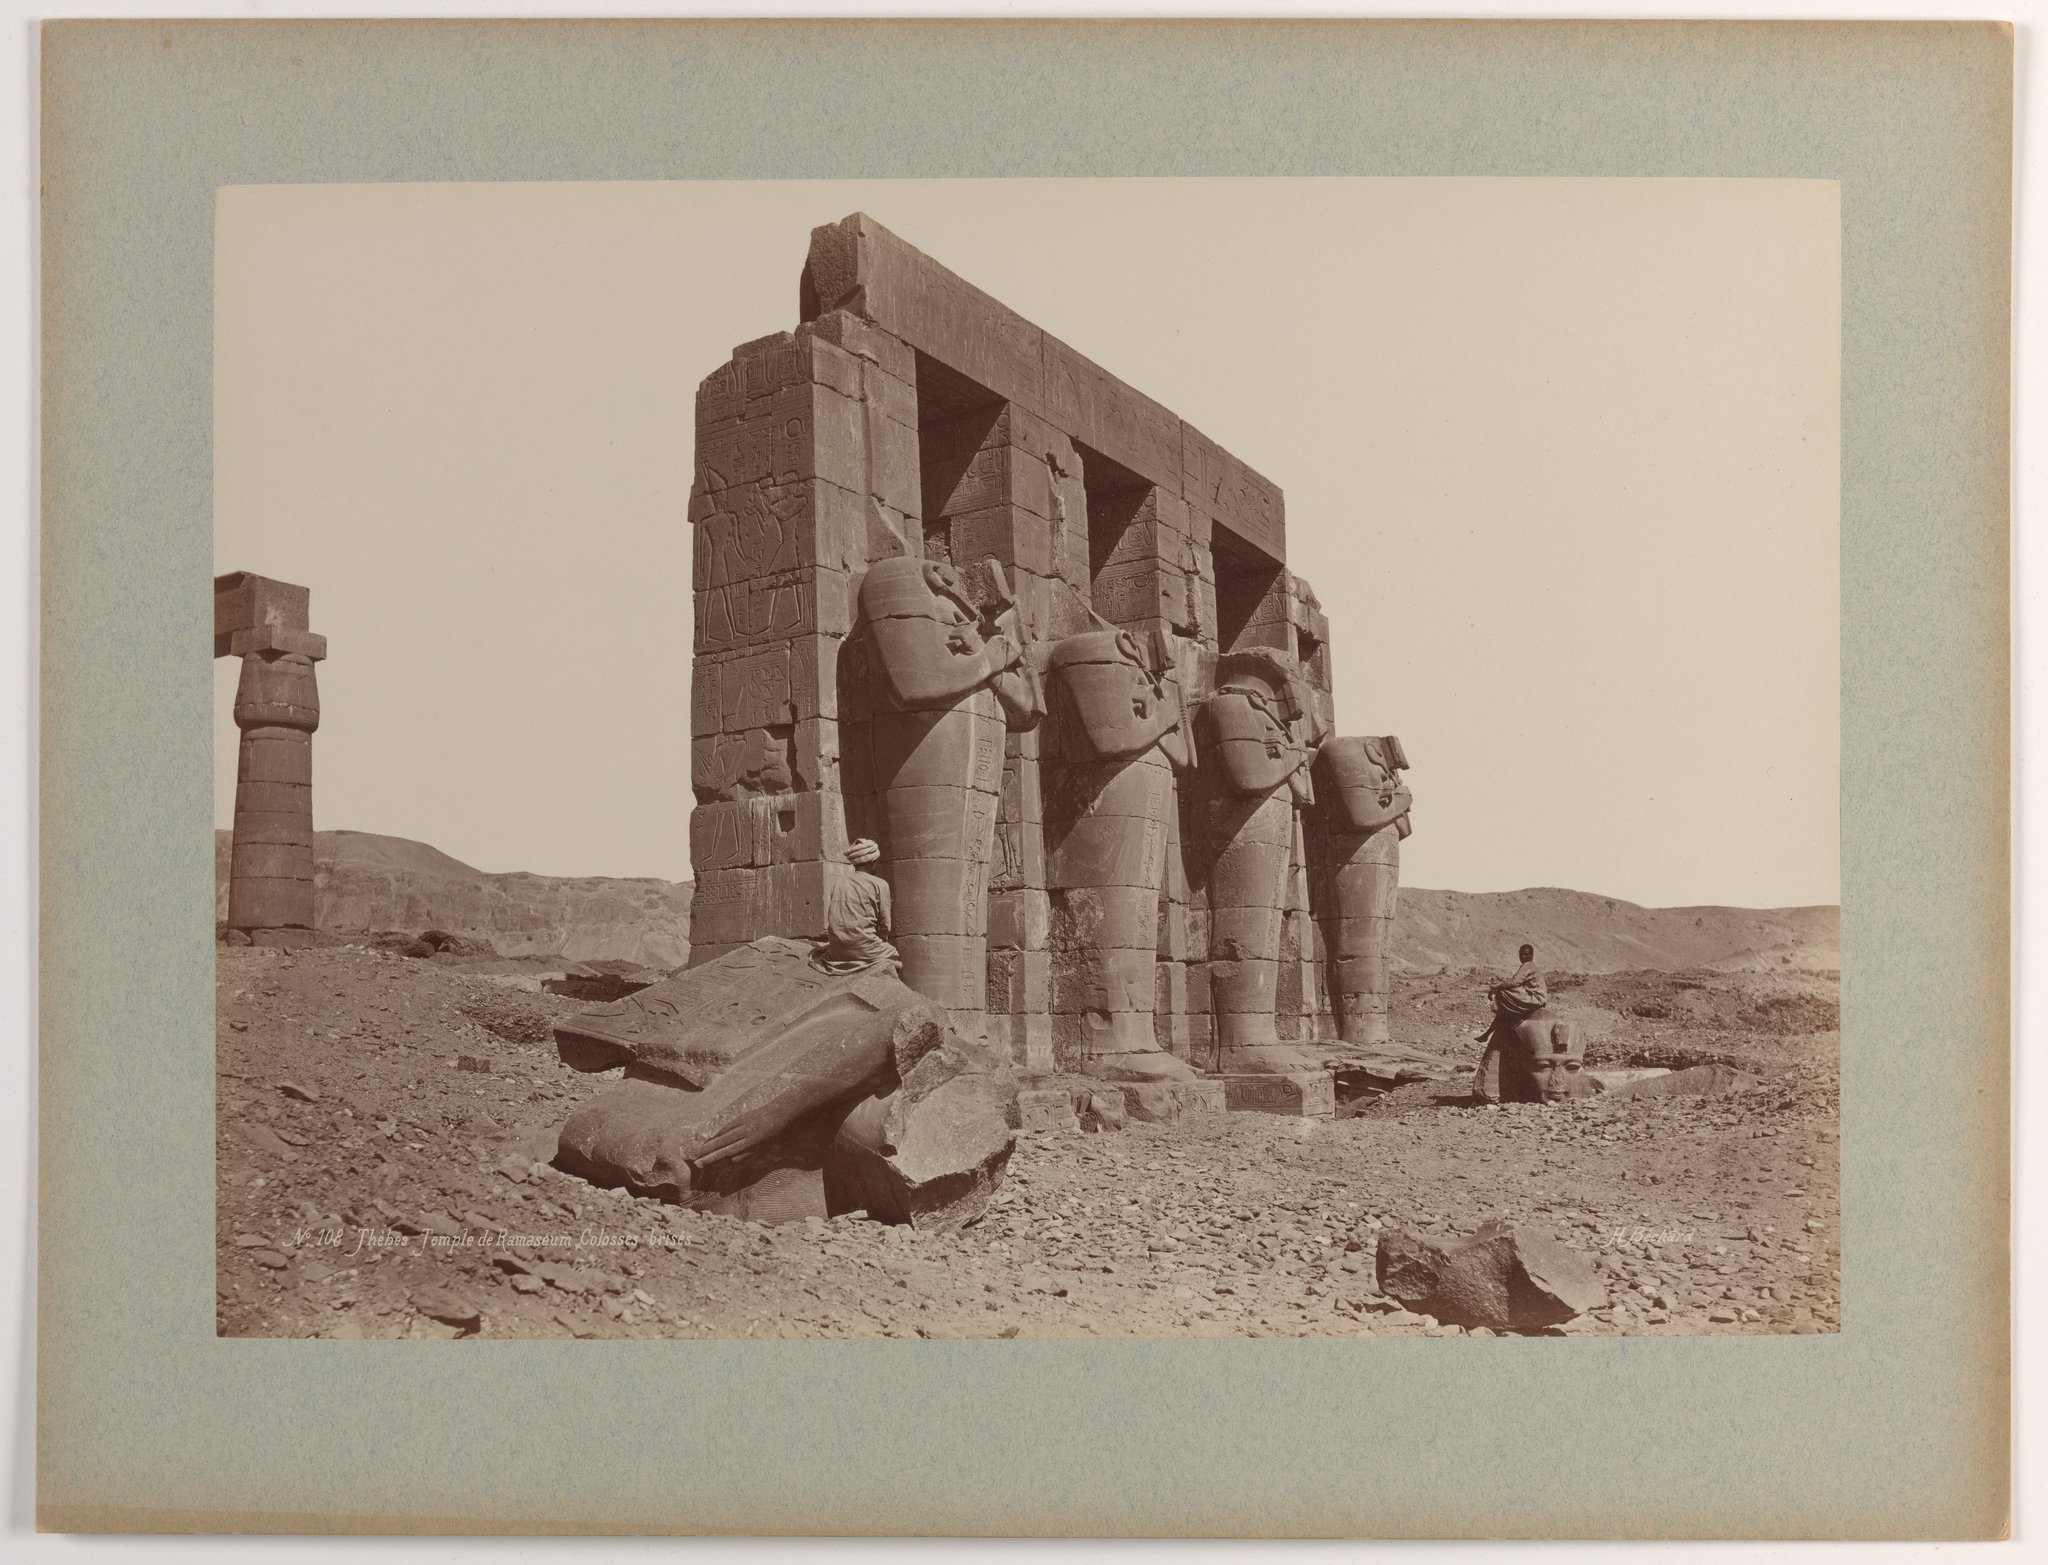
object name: photograph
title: Thèbes, Temple de Ramasseum, Colosses brisés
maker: emile béchard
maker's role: artist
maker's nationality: french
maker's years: 1859-1899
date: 1870-1879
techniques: albumen silver print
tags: sculpture,architecture,temples,ruins